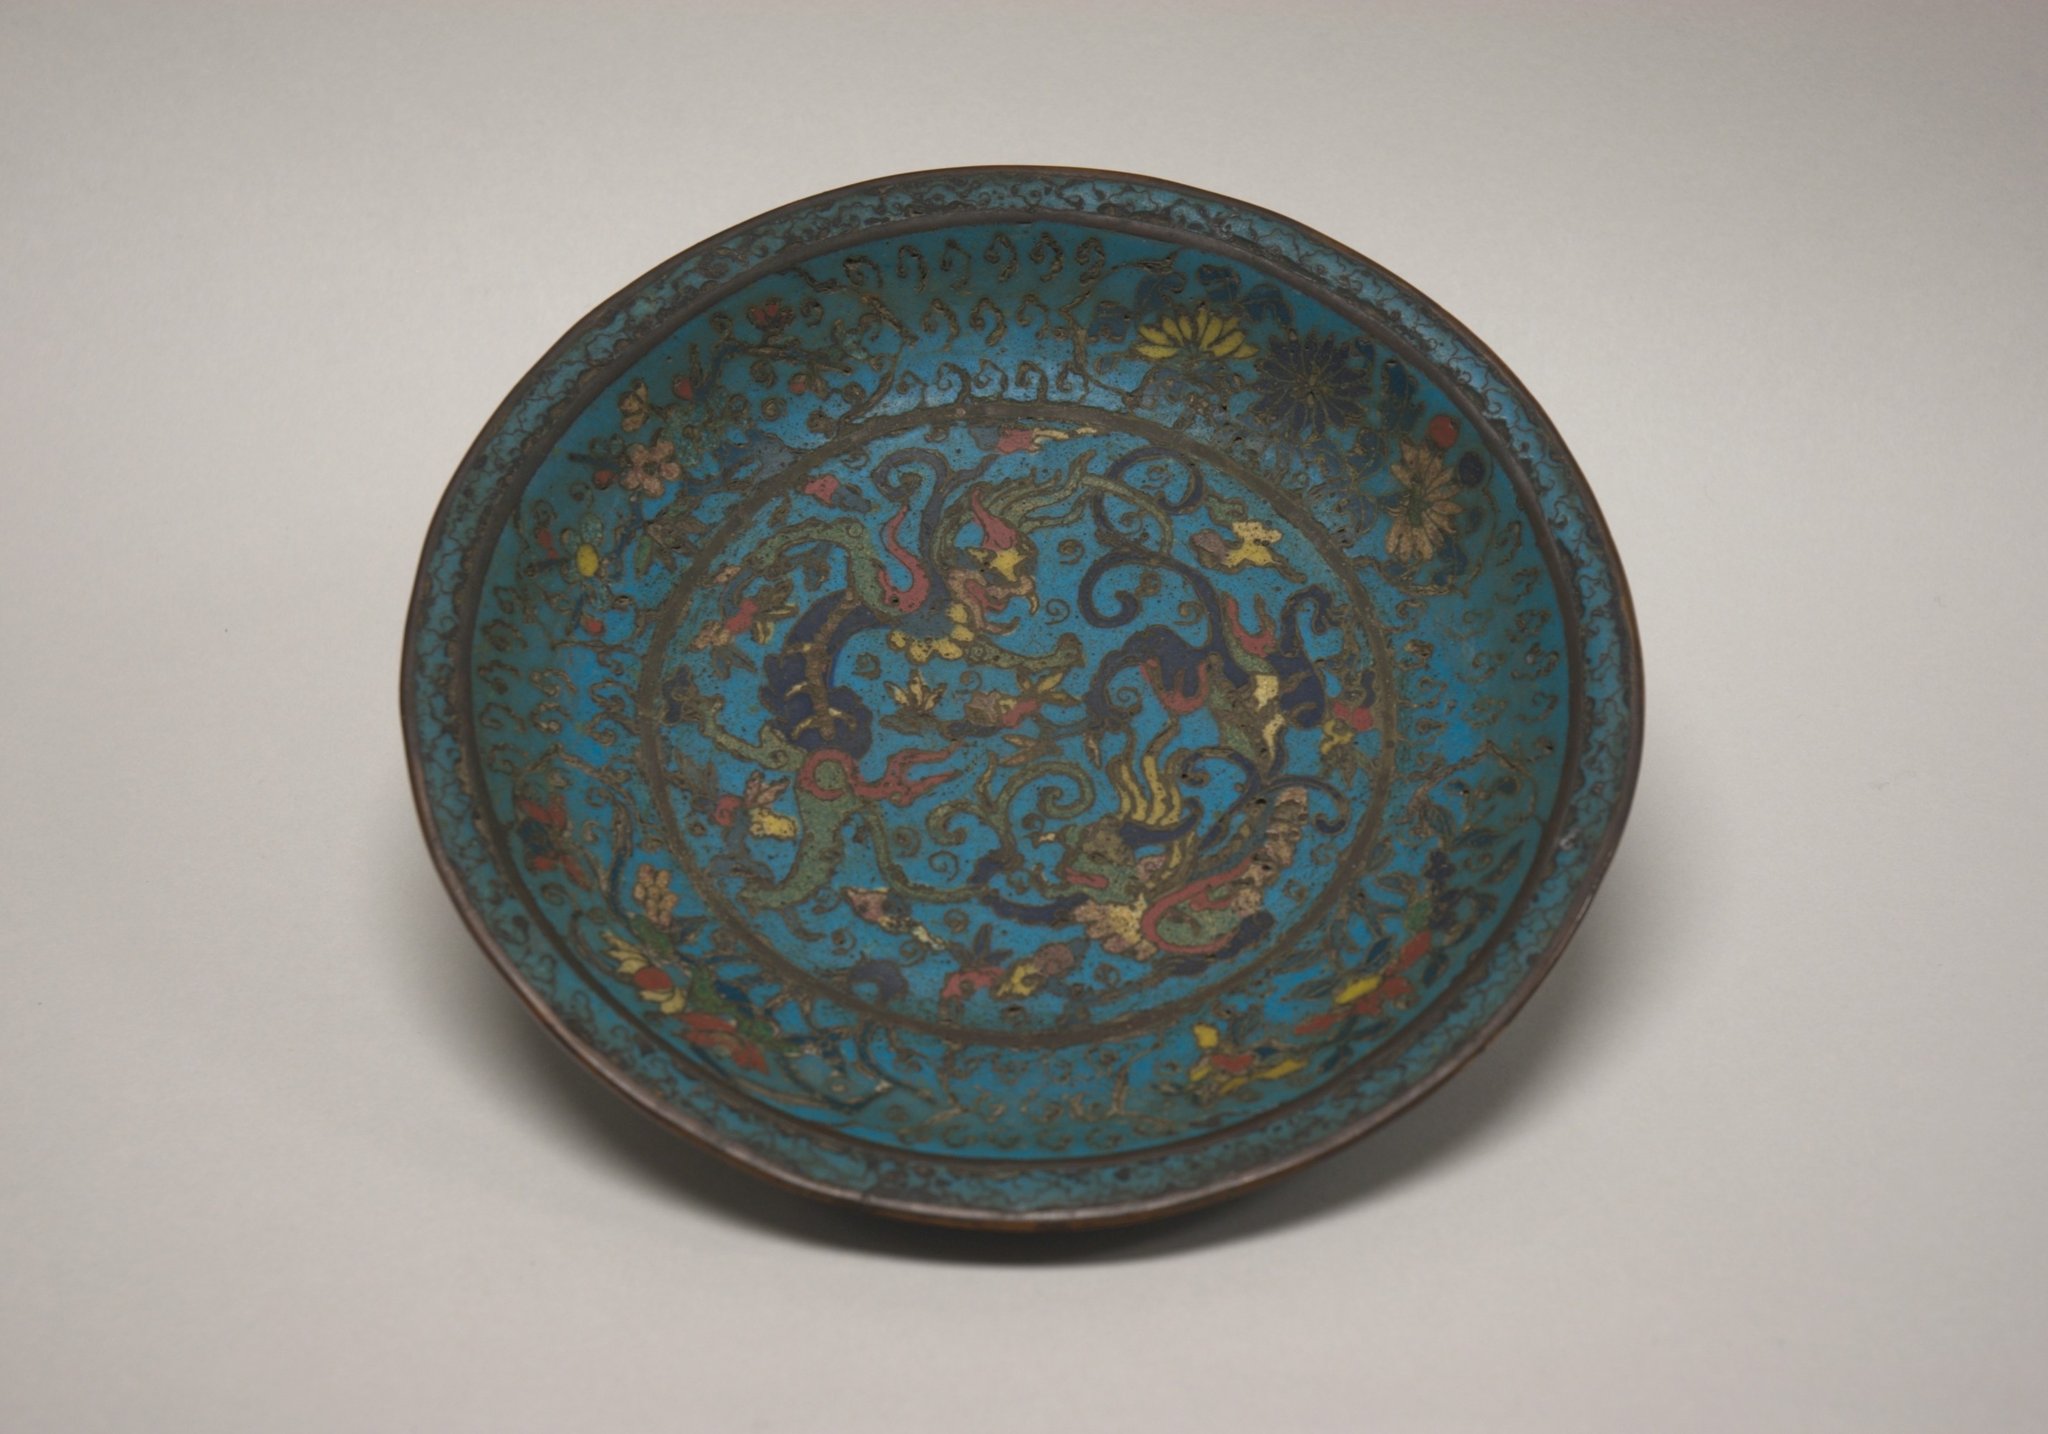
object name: dish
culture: chinese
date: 1368-1644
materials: copper, enamel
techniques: enamel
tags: flowers